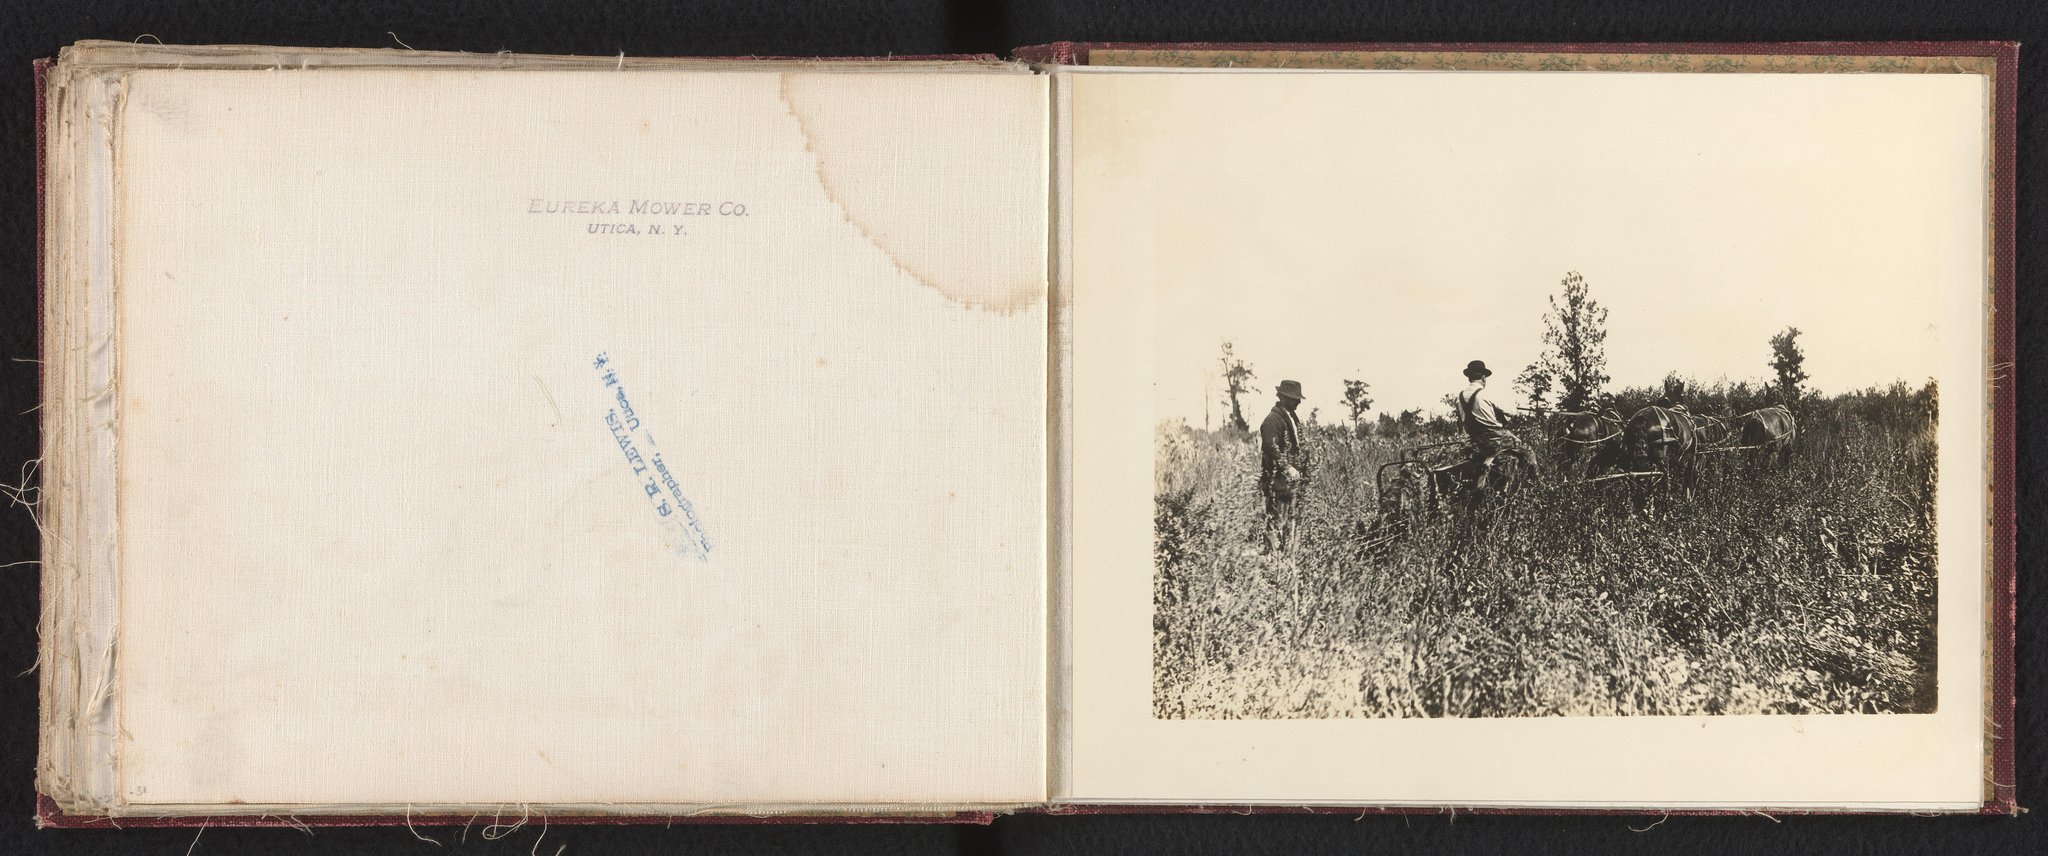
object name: photograph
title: Boeren op het land met een landbouwwerktuig van de Eureka Mower Co. te Utrica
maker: lewis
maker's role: fotograaf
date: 1915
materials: paper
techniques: gelatin silver print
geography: utica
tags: agricultural implements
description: Foto op 29e ongenummerde pagina na voorplat.